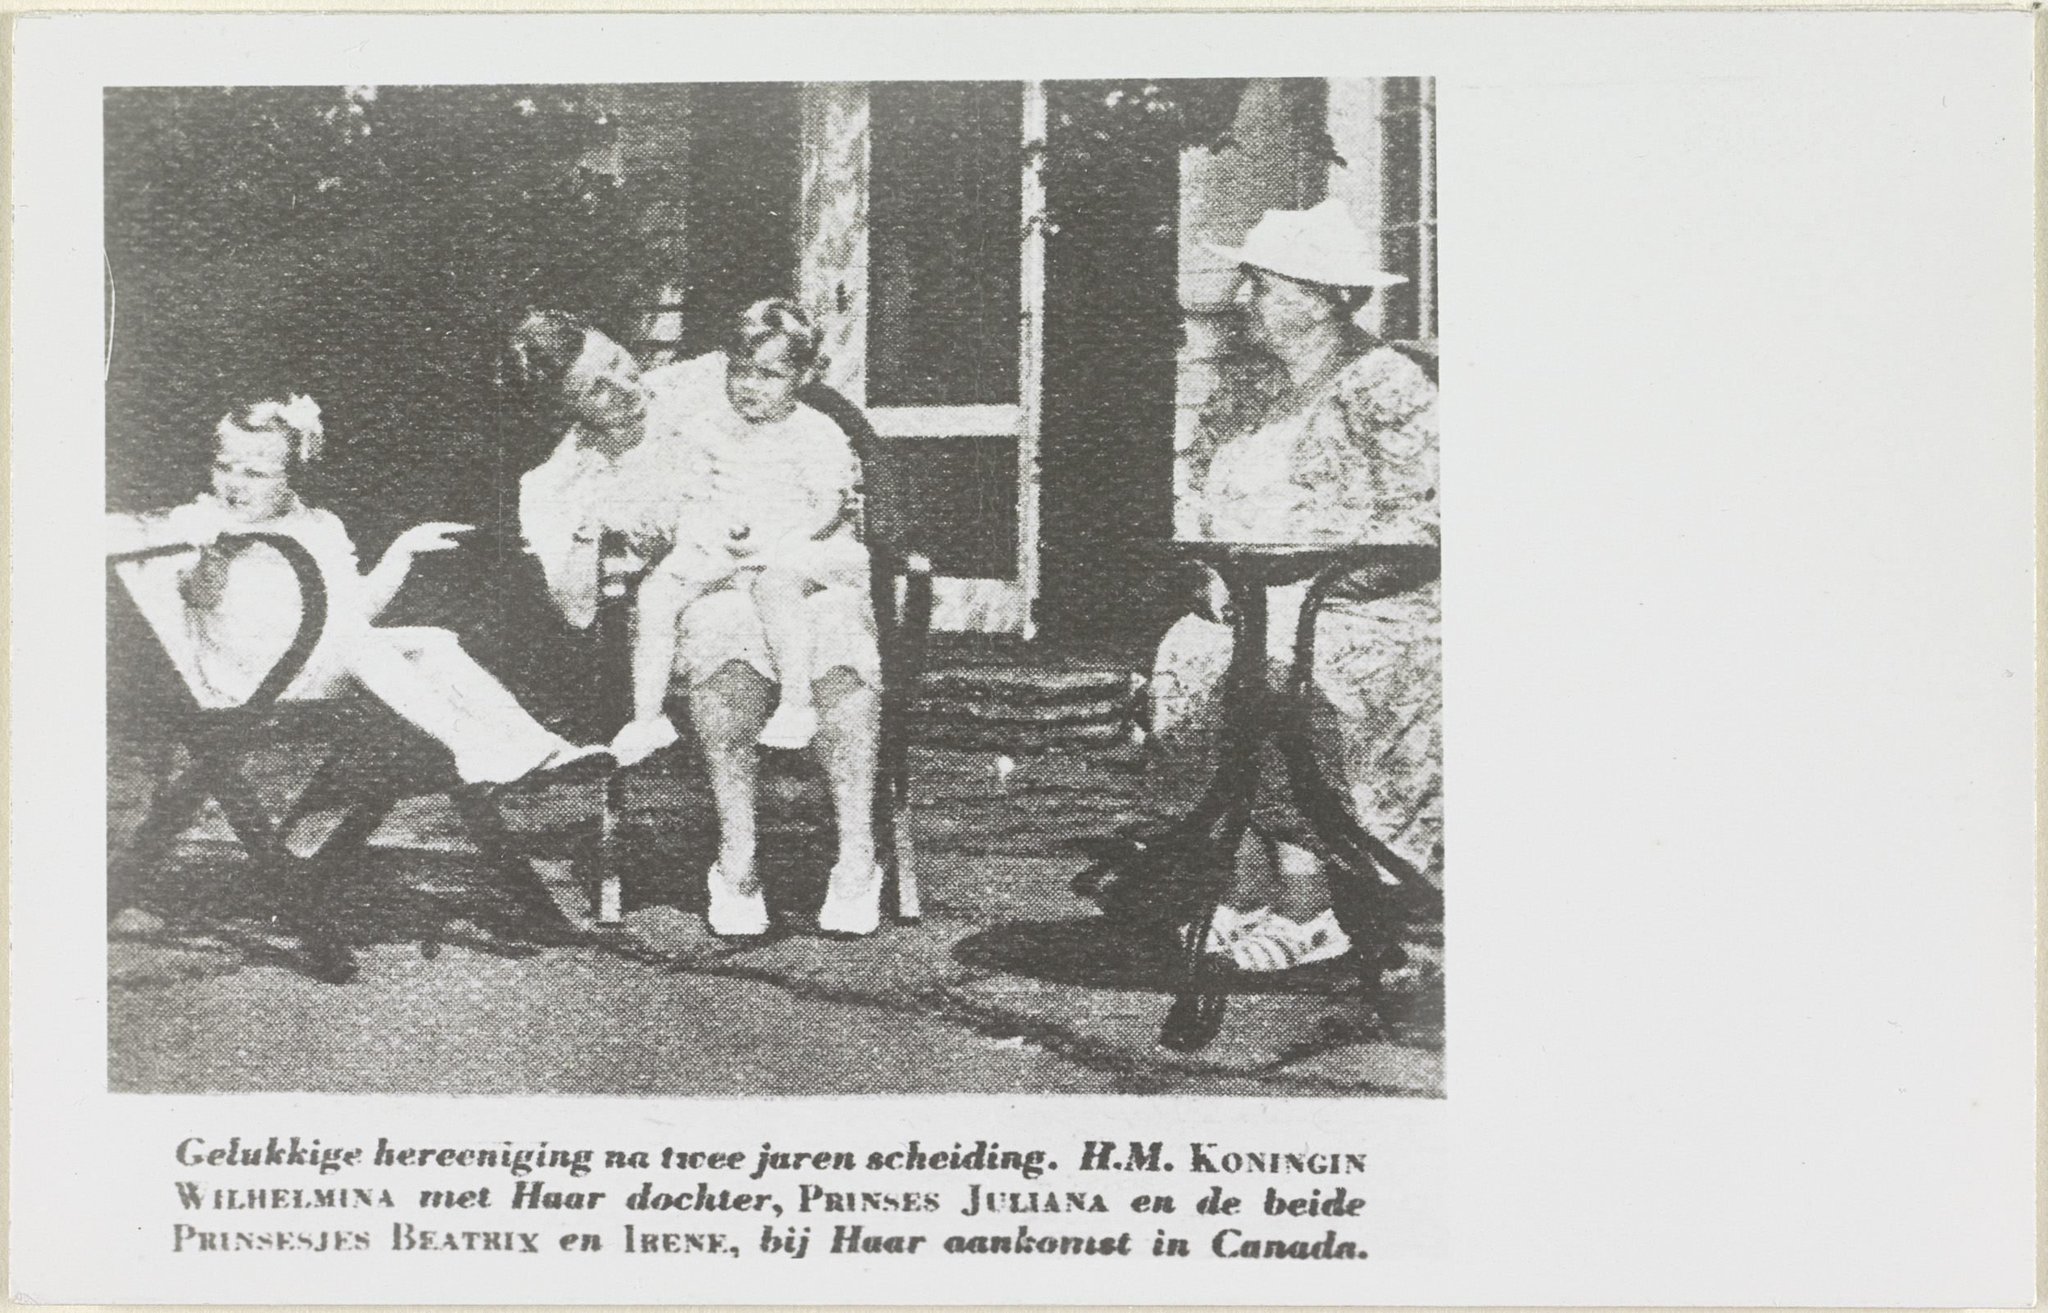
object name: photograph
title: Portret van Wilhelmina, koningin der Nederlanden, Juliana, koningin der Nederlanden, Beatrix, koningin der Nederlanden, en Irene, prinses der Nederlanden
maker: Anonymous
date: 1941-1943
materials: photographic support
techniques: photography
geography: netherlands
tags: the hague, print maker, wilhelmina of the netherlands, beatrix (koningin der nederlanden), juliana of the netherlands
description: De hier vermelde titel verwijst naar de hoogst verkregen titel van de geportretteerde, niet per se naar de titel die de geportretteerde op deze voorstelling draagt. Foto naar een rotogravure naar een foto.